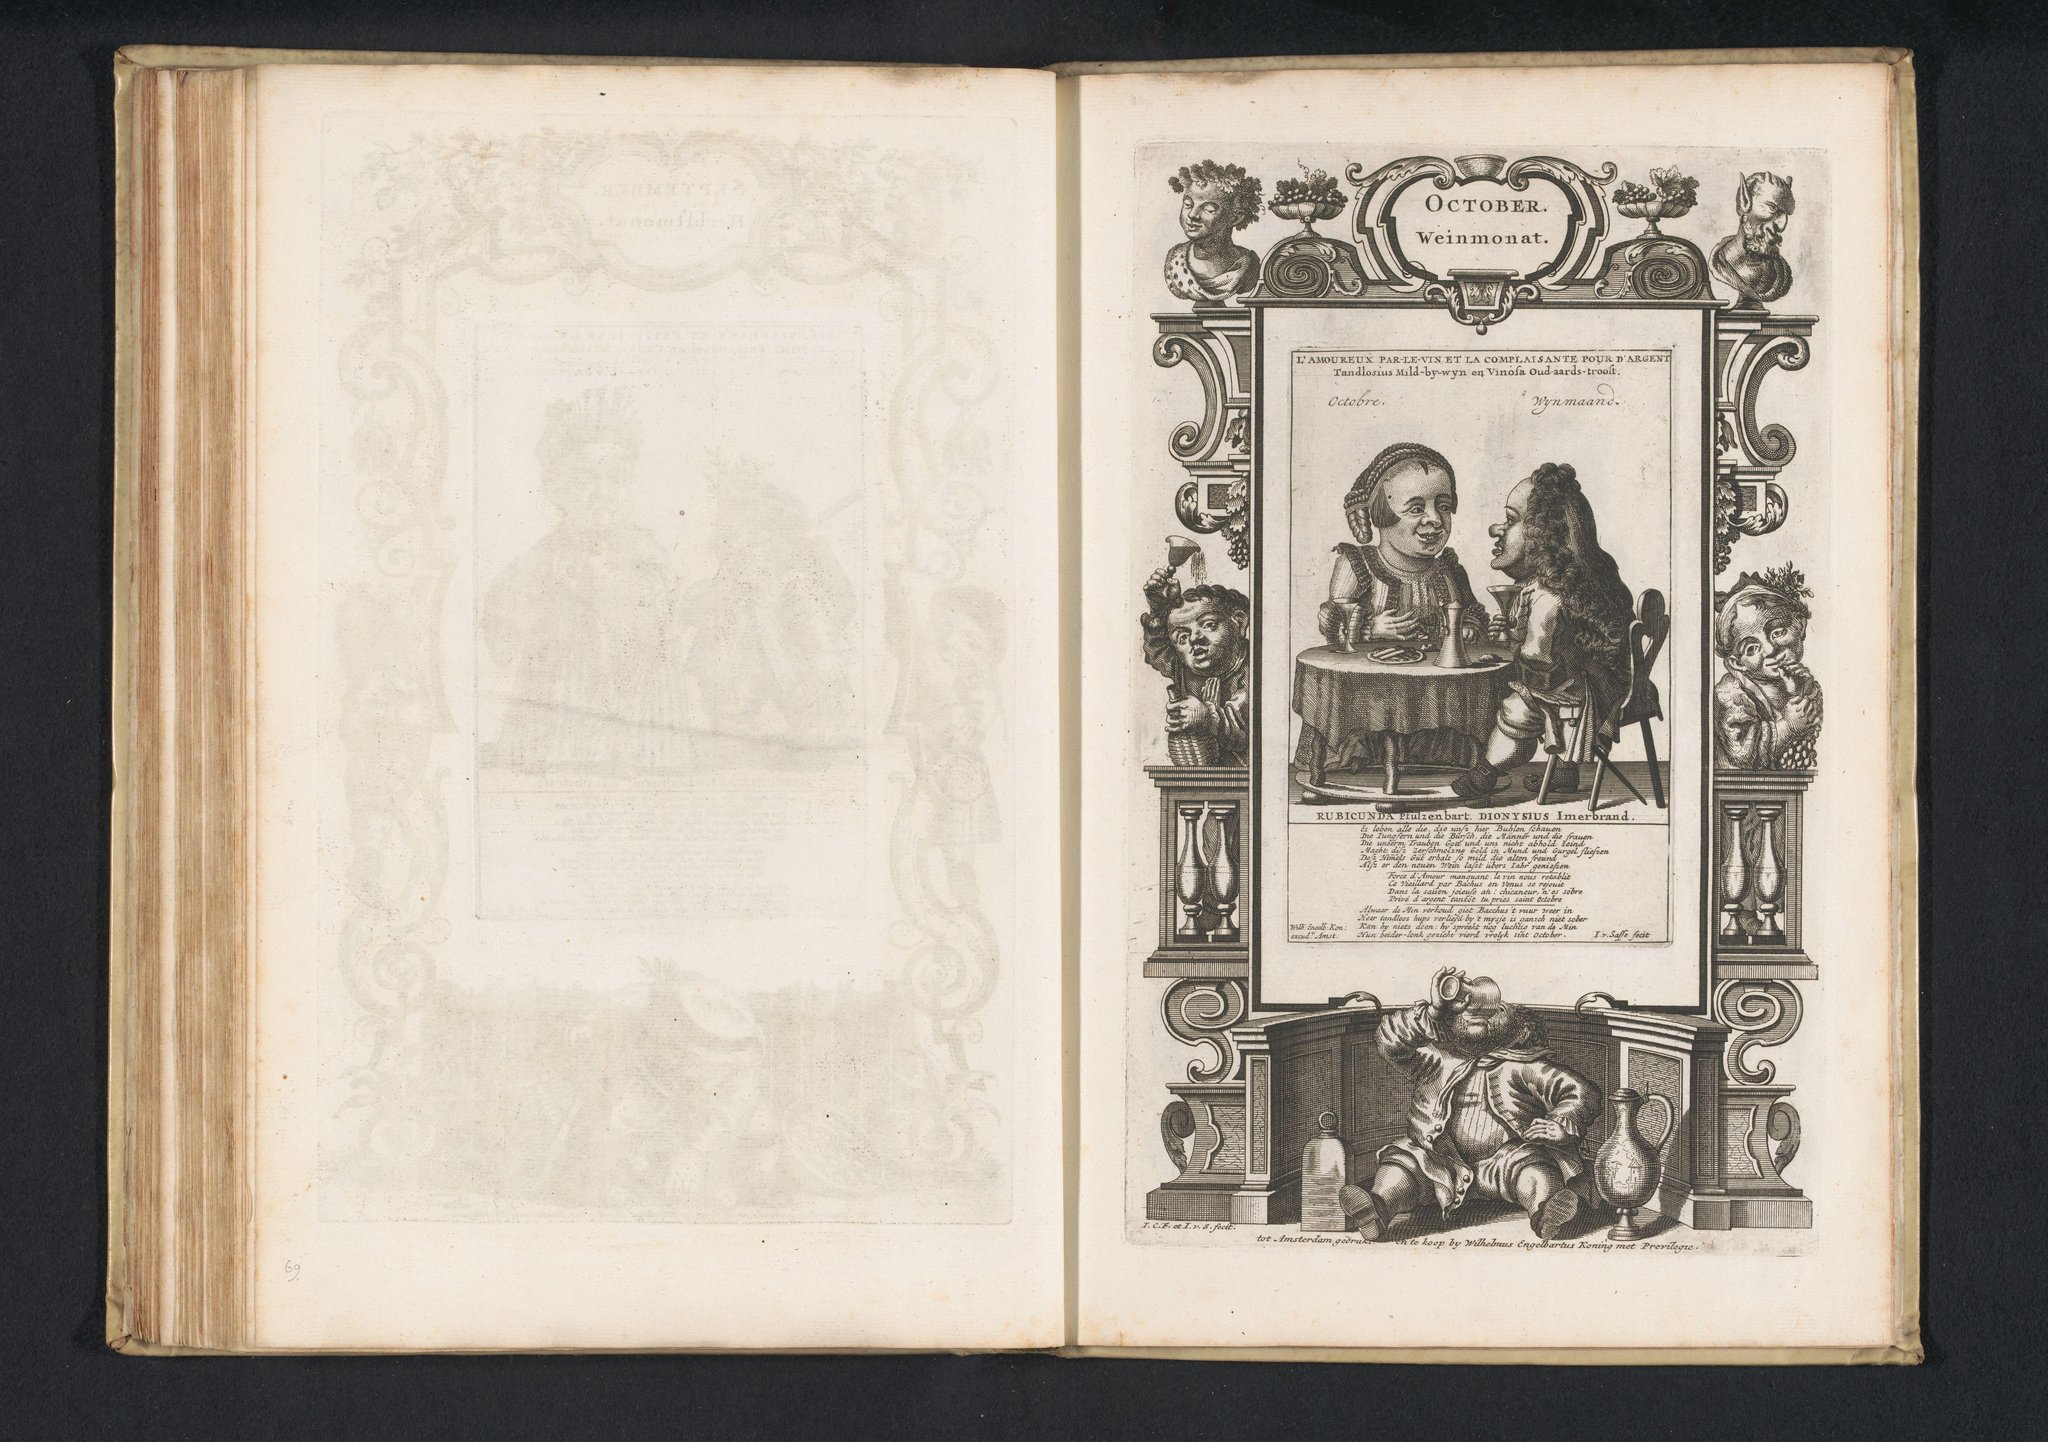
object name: caricature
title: October. Weinmonat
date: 1716-1720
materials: paper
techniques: engraving, etching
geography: northern netherlands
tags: caricatures (human types), wine ~ alcoholic drinks (+ taking (particular) foodstuffs: eating, drinking, smoking, chewing, etc.), little people, october and its 'labours'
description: Twee kleine mensen voor de maand oktober (Wijnmaand). Een man en een vrouw drinken wijn zittend aan een tafel. In het onderschrift verzen in het Duits, Frans en Nederlands. Afdruk binnen een decoratieve omlijsting gedrukt van een aparte plaat voor de maand oktober met onderaan een kleine mens die een glas wijn drinkt. Onderdeel van deel III (een serie van de twaalf maanden) in de tweede Nederlandse gebonden uitgave uit 1720 (en gerelateerd aan de Windhandel in dat jaar) van een serie karikaturen van kleine mensen, bekend als Het Dwergentooneel, deels gekopieerd naar een ouder Duits voorbeeld.